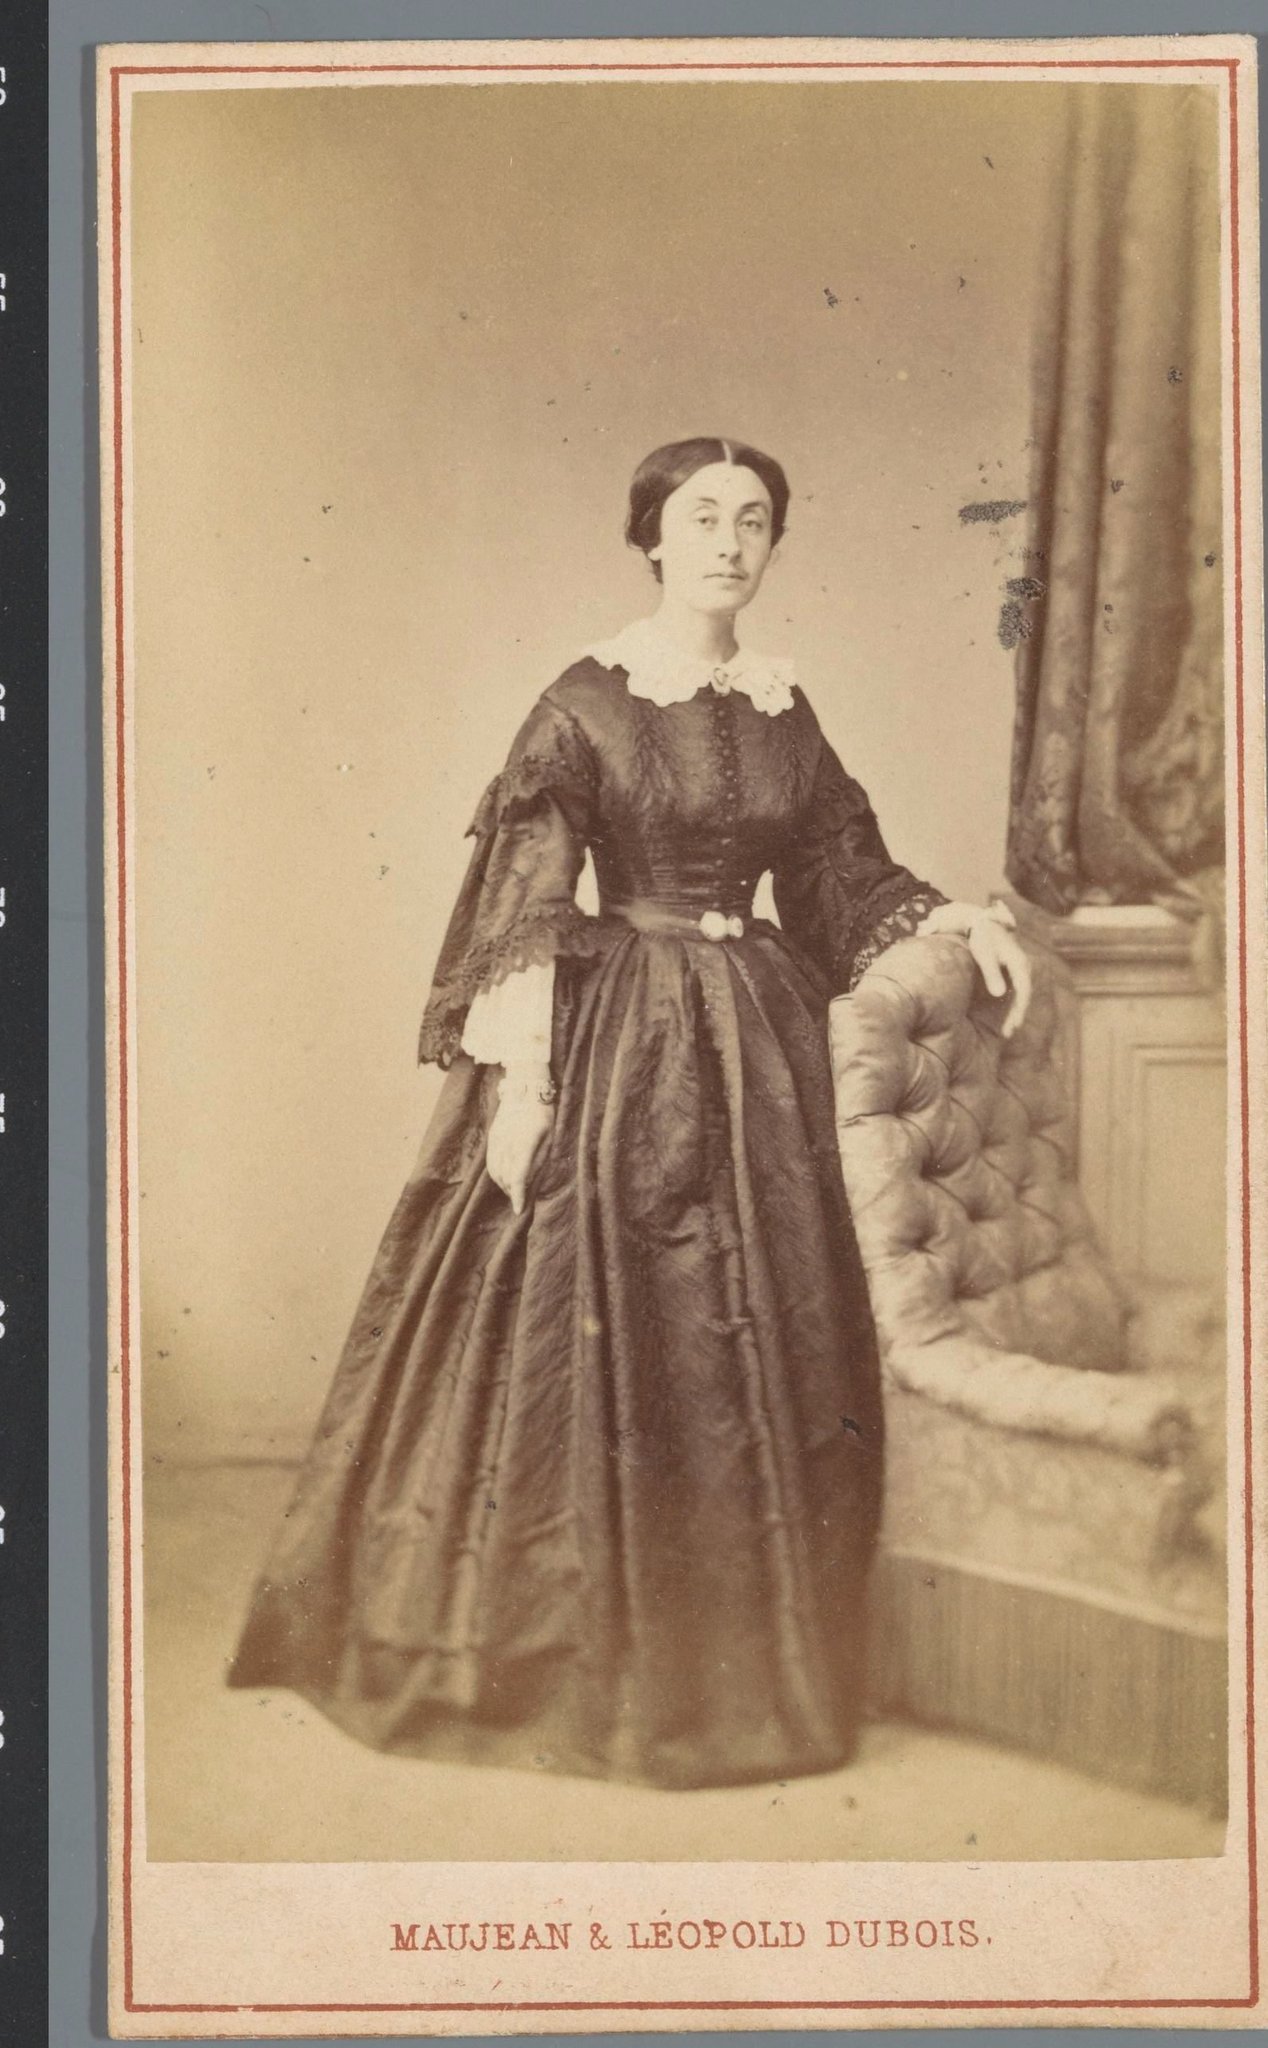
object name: carte de visite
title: Portret van een onbekende vrouw bij een fauteuil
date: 1850-1870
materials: cardboard, paper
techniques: albumen print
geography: paris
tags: adult woman, anonymous historical person portrayed, paris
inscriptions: inscription: ‘Maujean & Léopold Dubois.’, inscription: ‘Photographie Maujean/ et/ Léopold Dubois/ 30, Rue du Faubourg St. Honoré/ 35, Rue de Boissy d'Anglas/ (Ancienne Rue de la Madeleine)/ Paris/ 70.000 Clichés conservés./ English spoken./ No...’, number: ‘8079’